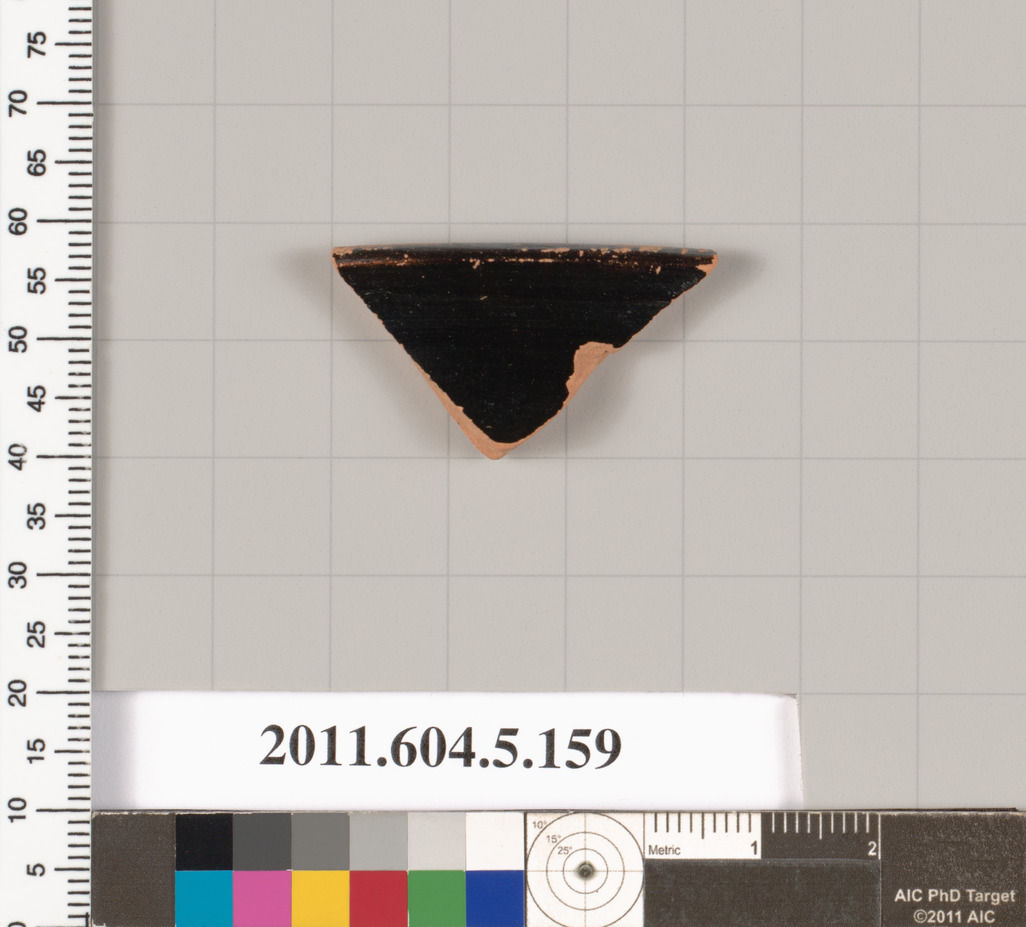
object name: kylix fragment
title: Terracotta rim fragment of a kylix (drinking cup)?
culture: greek, attic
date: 600-401 BCE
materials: terracotta